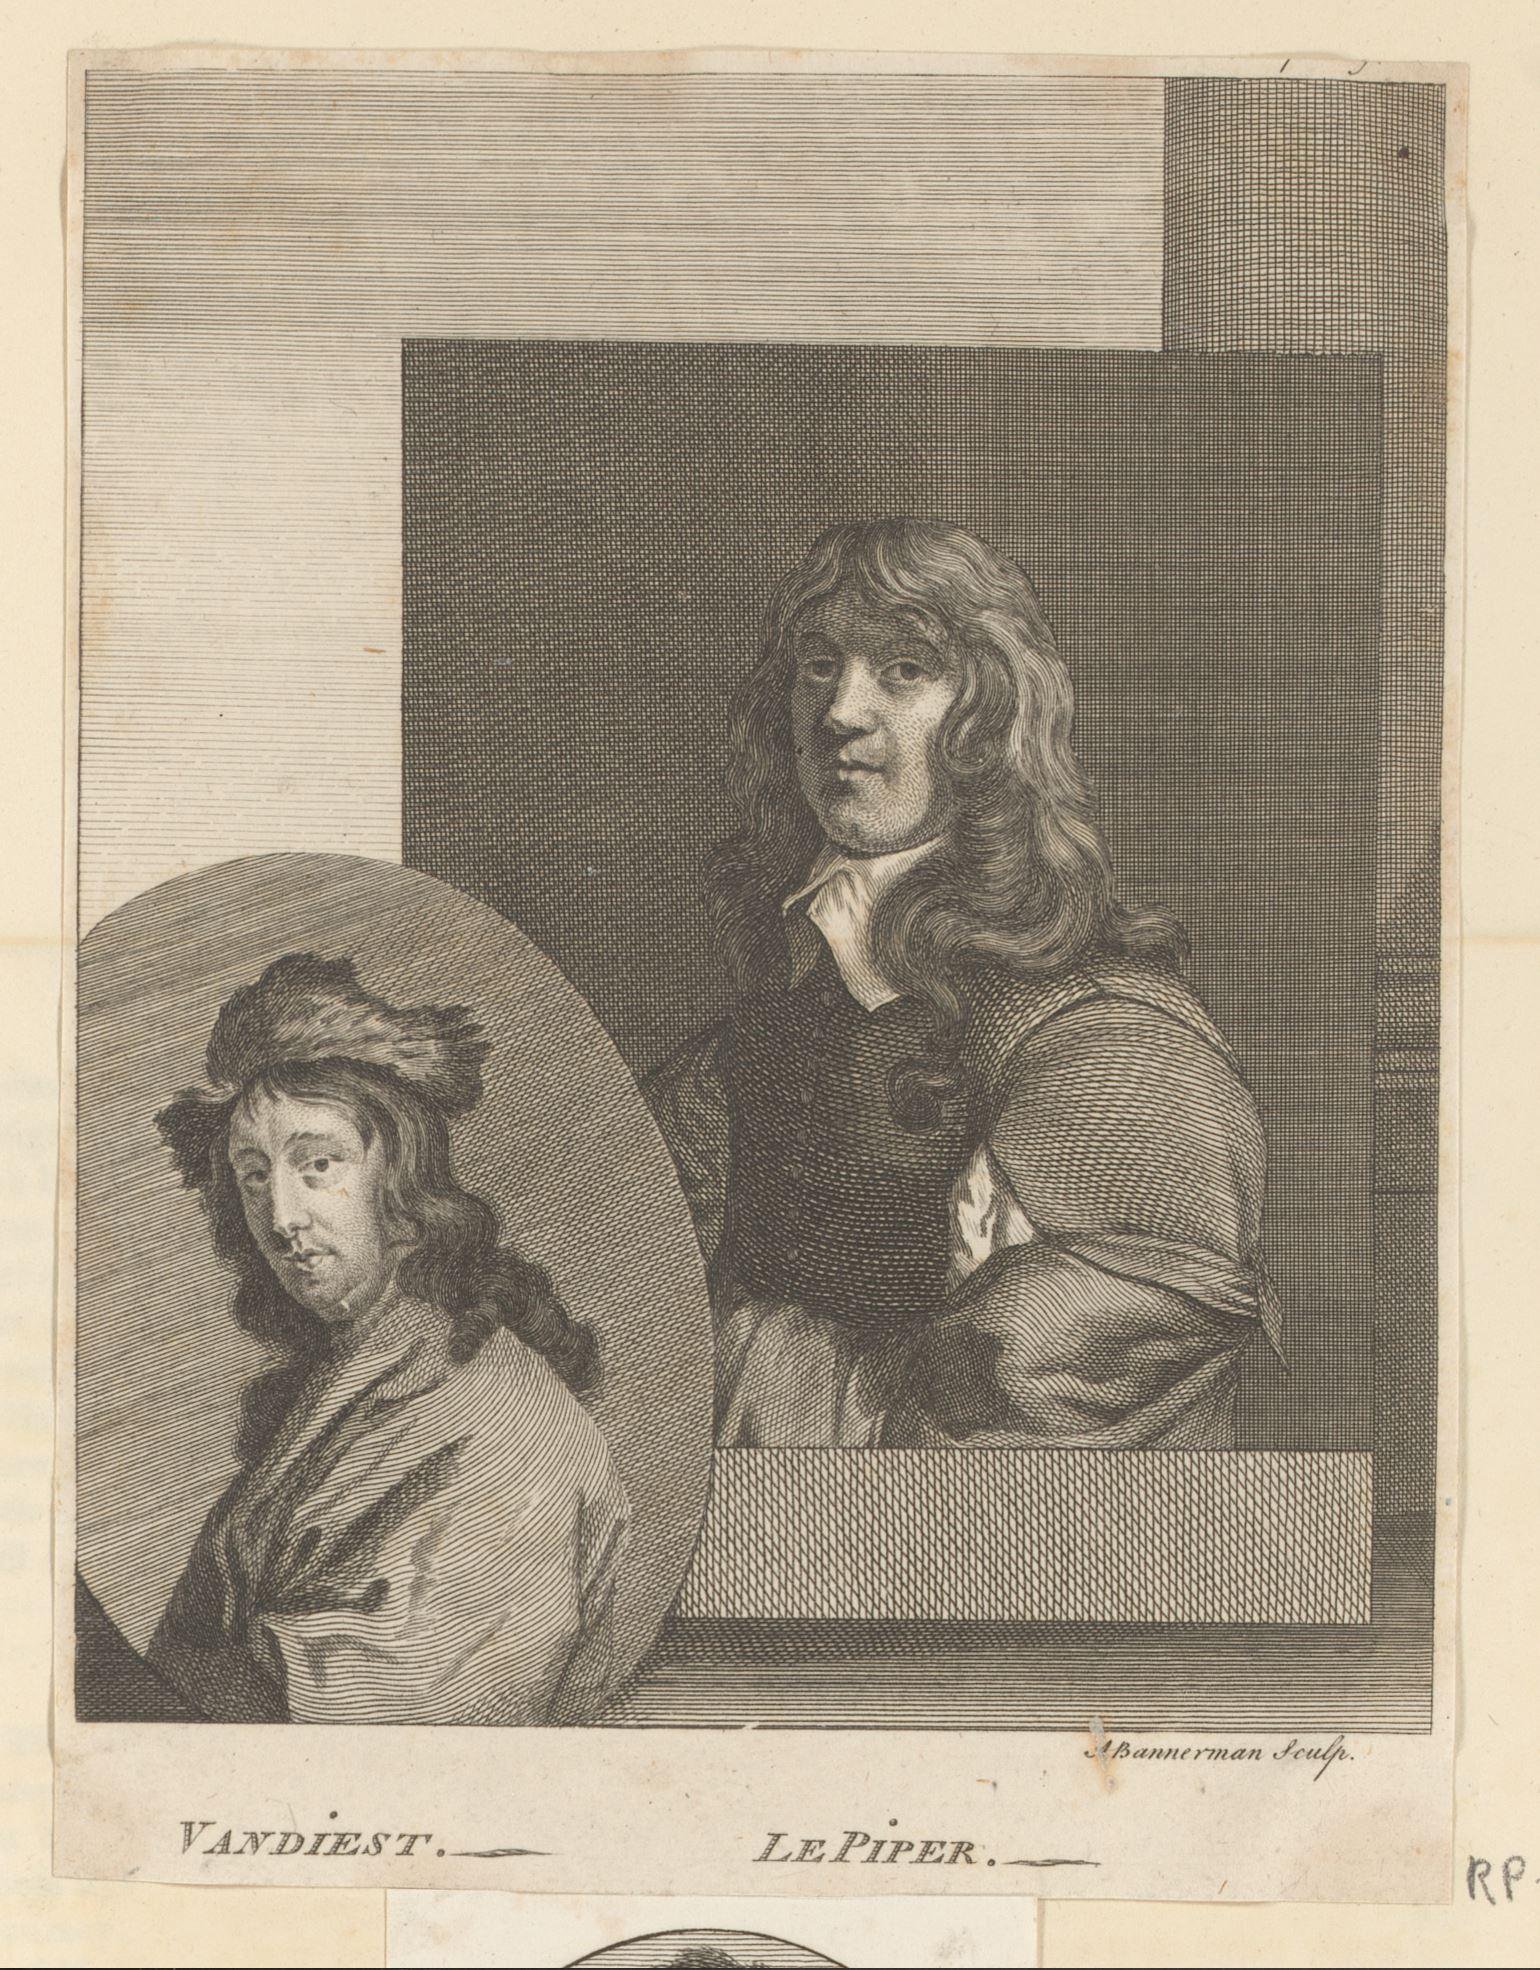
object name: print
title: Vandiest / Le Piper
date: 1730-1763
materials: paper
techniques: engraving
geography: london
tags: the hague, london, painter, print maker, adriaen van diest, historical persons, portrait, self-portrait of painter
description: Prent uit: Walpole, Horace. Anecdotes of painting in England : with some account of the principal artists : and incidental notes on other arts; collected by the late Mr. George Vertue : and now digested and published from his original Mss. / by Horace Walpole. 4 dln. Londen: Horace Walpole, [1762-1789], dl. 3, p. 129. De samensteller heeft deze prent in het album geplakt als illustratie bij: Pilkington, Matthew en Johann Heinrich Füssli. A dictionary of painters, from the revival of the art to the present period. 4 dln. Londen: John Crowder, 1805, dl. 1, p. 155.